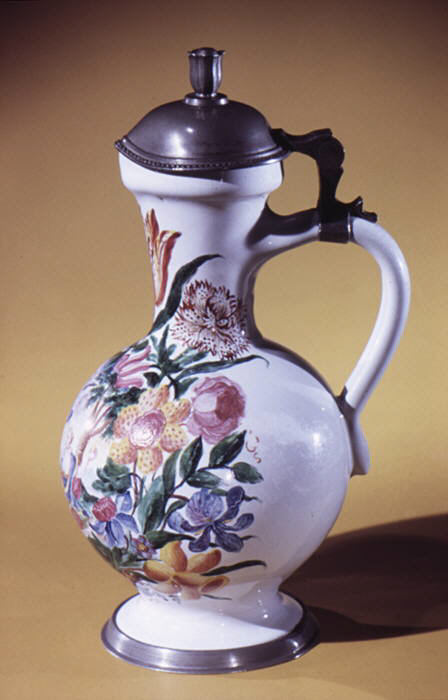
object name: jug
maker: abraham helmhack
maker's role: maker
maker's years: 1654-1724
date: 1667-1700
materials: earthenware, pewter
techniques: glazing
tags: flowers